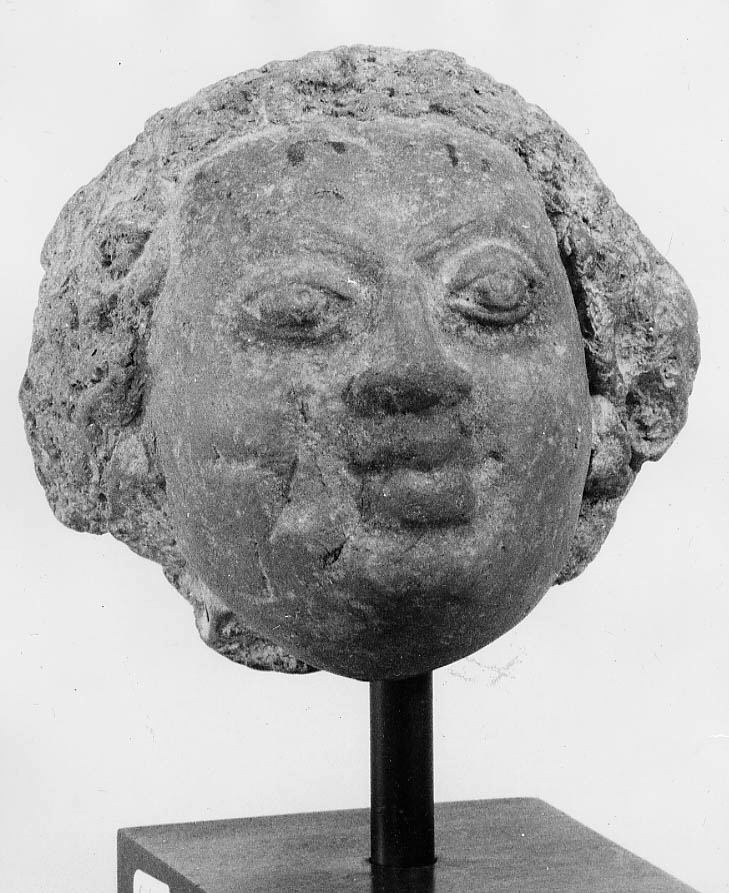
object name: plaque fragment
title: Head of a Male Figure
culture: indian, uttar pradesh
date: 401-500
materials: terracotta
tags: gupta,faces,heads